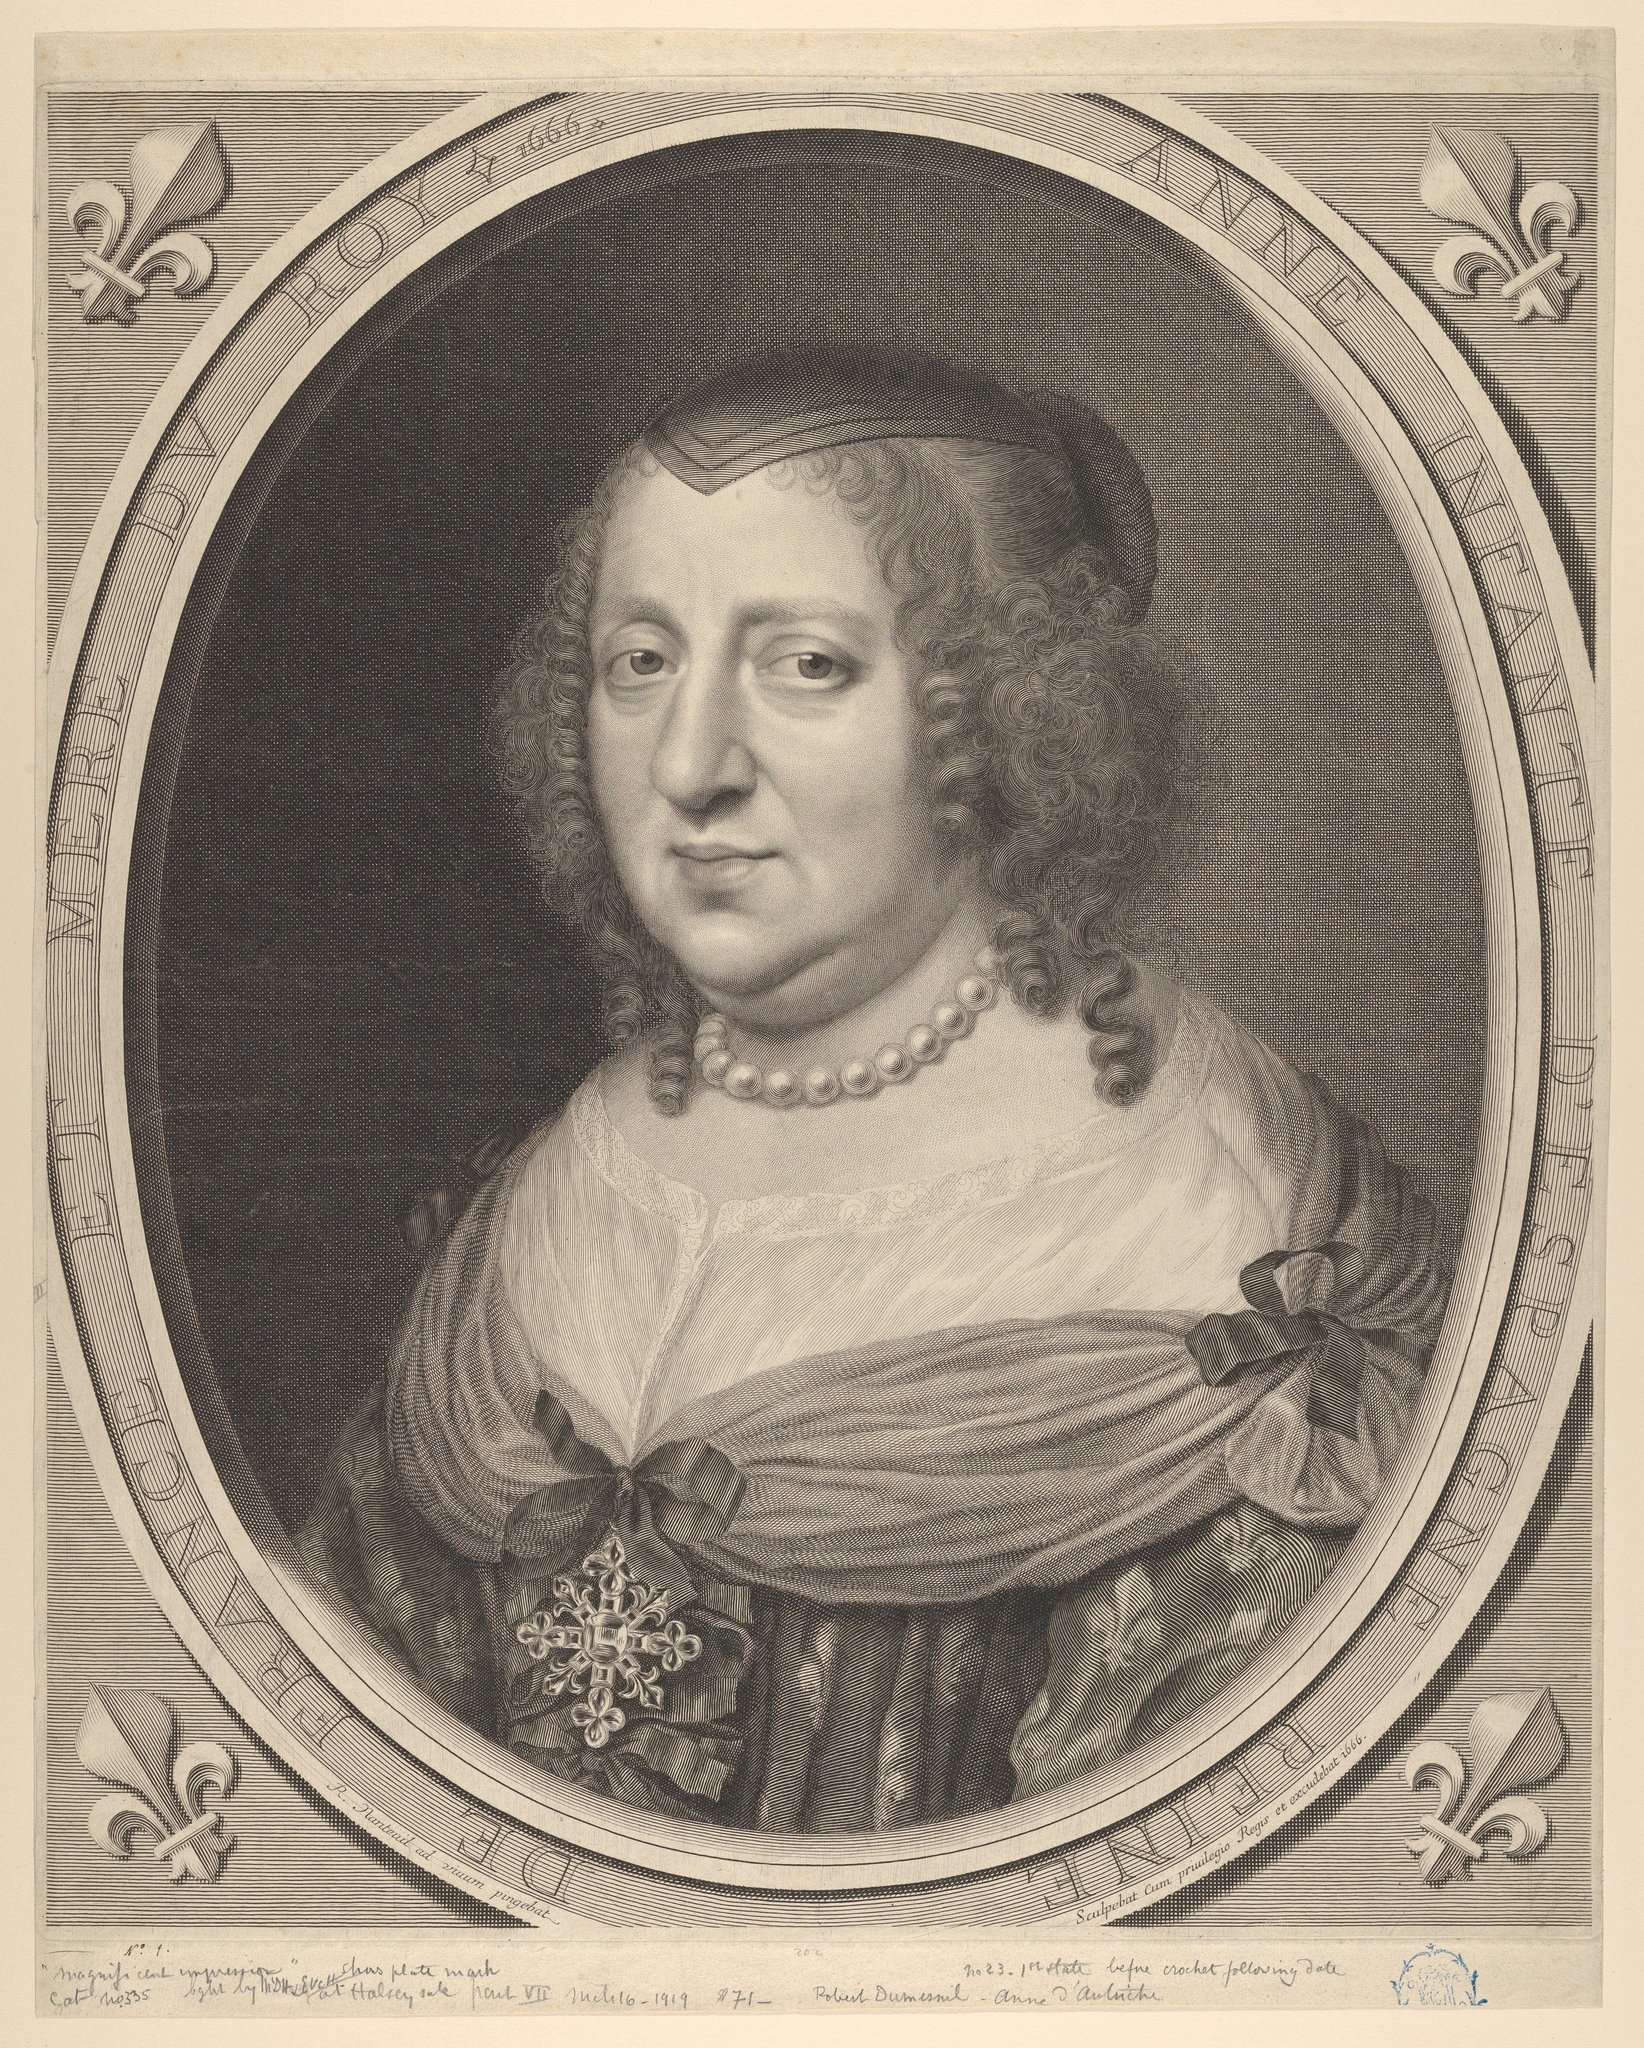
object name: print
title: Anne of Austria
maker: robert nanteuil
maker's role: artist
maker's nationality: french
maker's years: 1623-1678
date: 1671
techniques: engraving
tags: queens,portraits